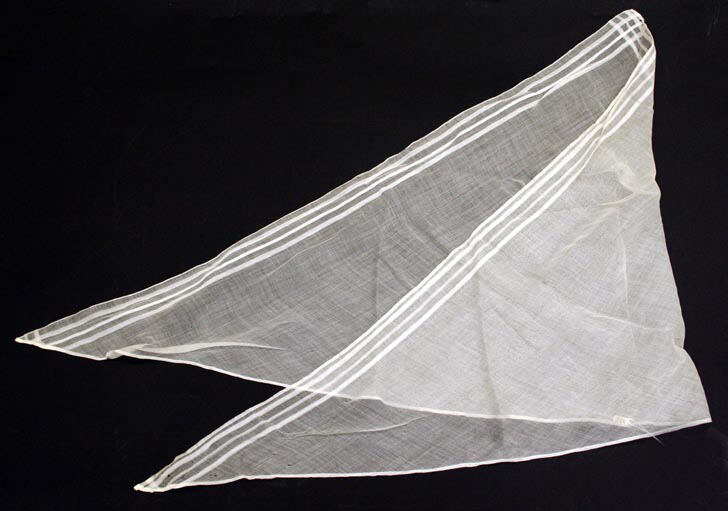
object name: kerchief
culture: american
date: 1700-1942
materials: cotton